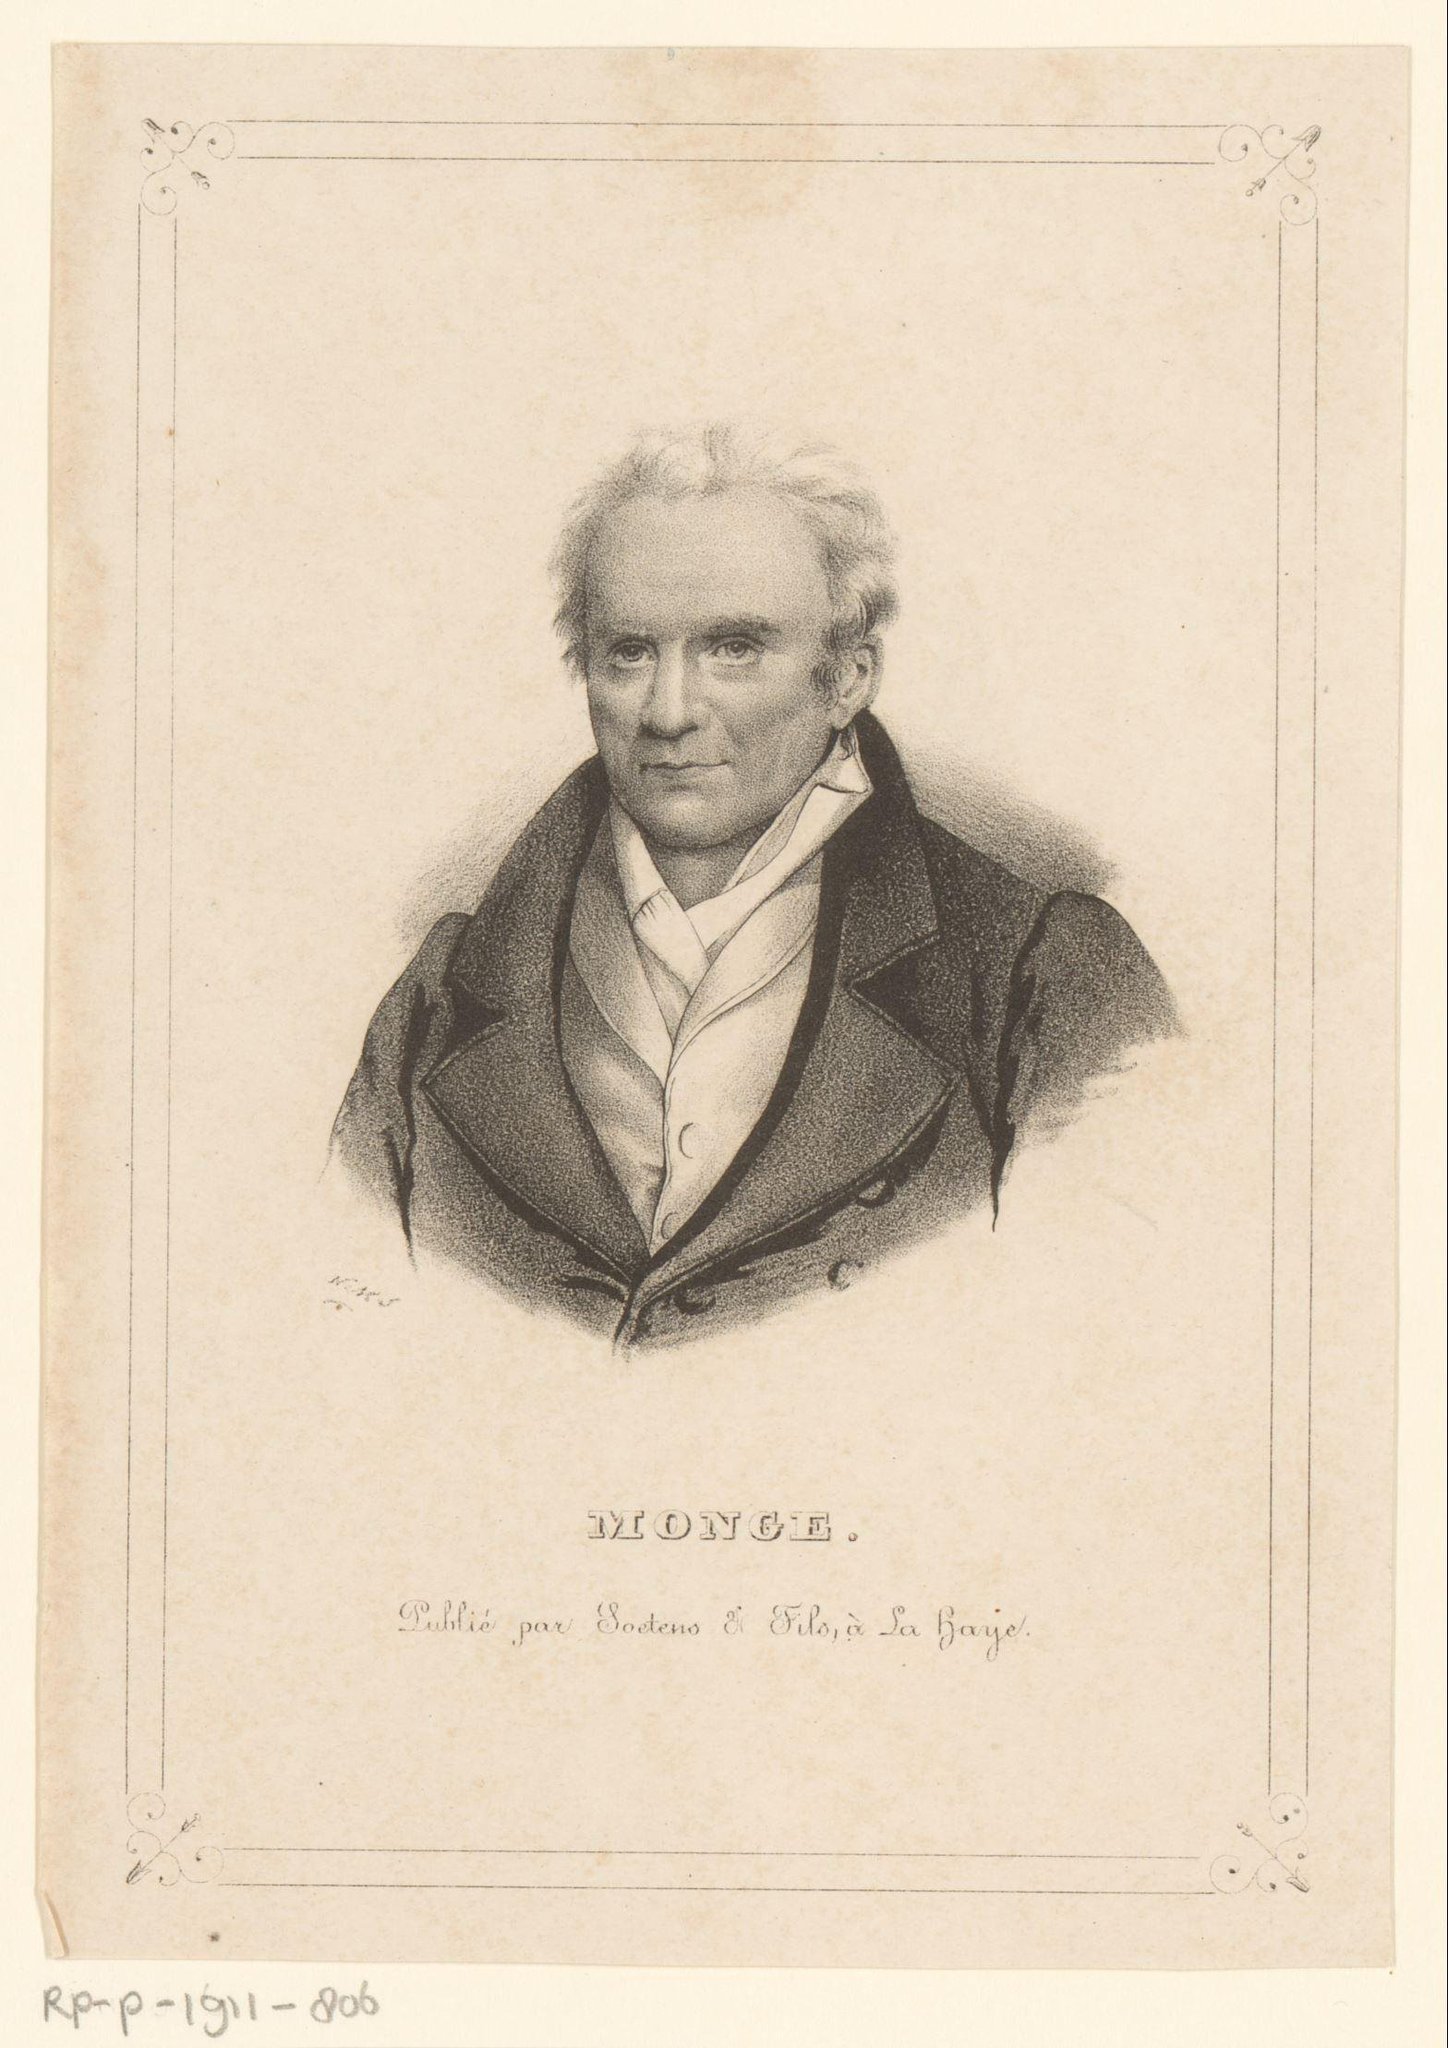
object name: print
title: Portret van Gaspard Monge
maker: nicolaas martinus schild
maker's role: draughtsman, print maker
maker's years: 1822-1840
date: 1837-1840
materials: paper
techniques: lithograph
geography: the hague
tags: paris, historical persons (+ (full) bust portrait)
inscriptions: collector's mark: Lugt 2228